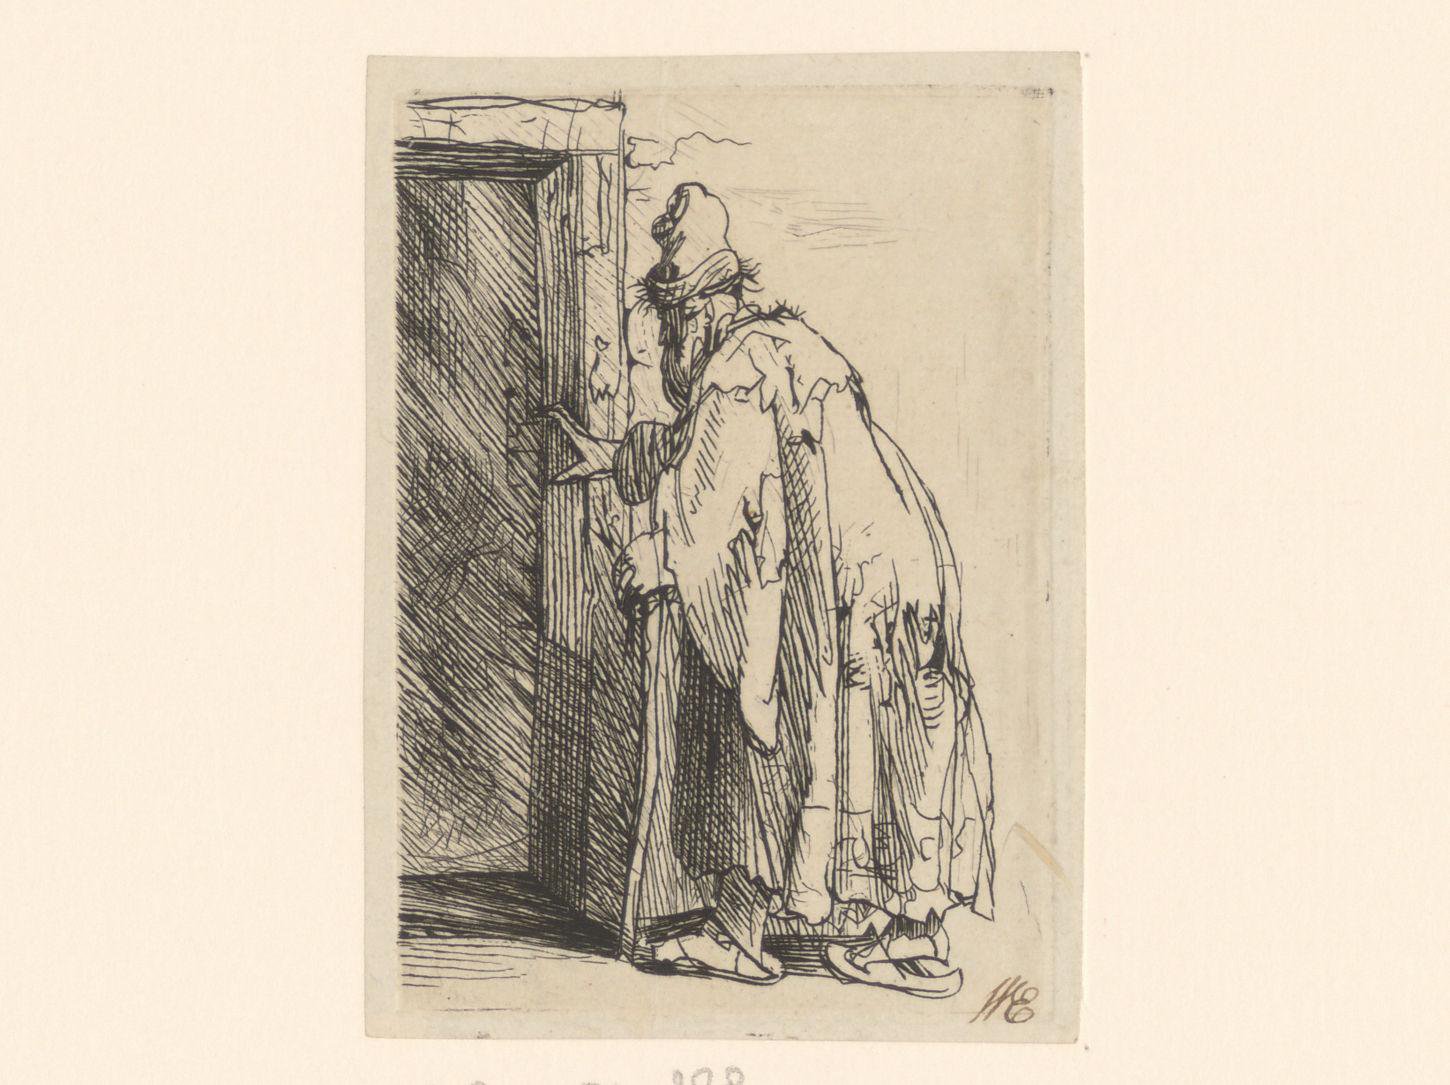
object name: print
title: Twaalf etsen naar Rembrandt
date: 1824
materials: paper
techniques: etching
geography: london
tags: tobit's blindness (tobit 2 - 3:6)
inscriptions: collector's mark: Lugt 2228, collector's mark: Lugt 2617